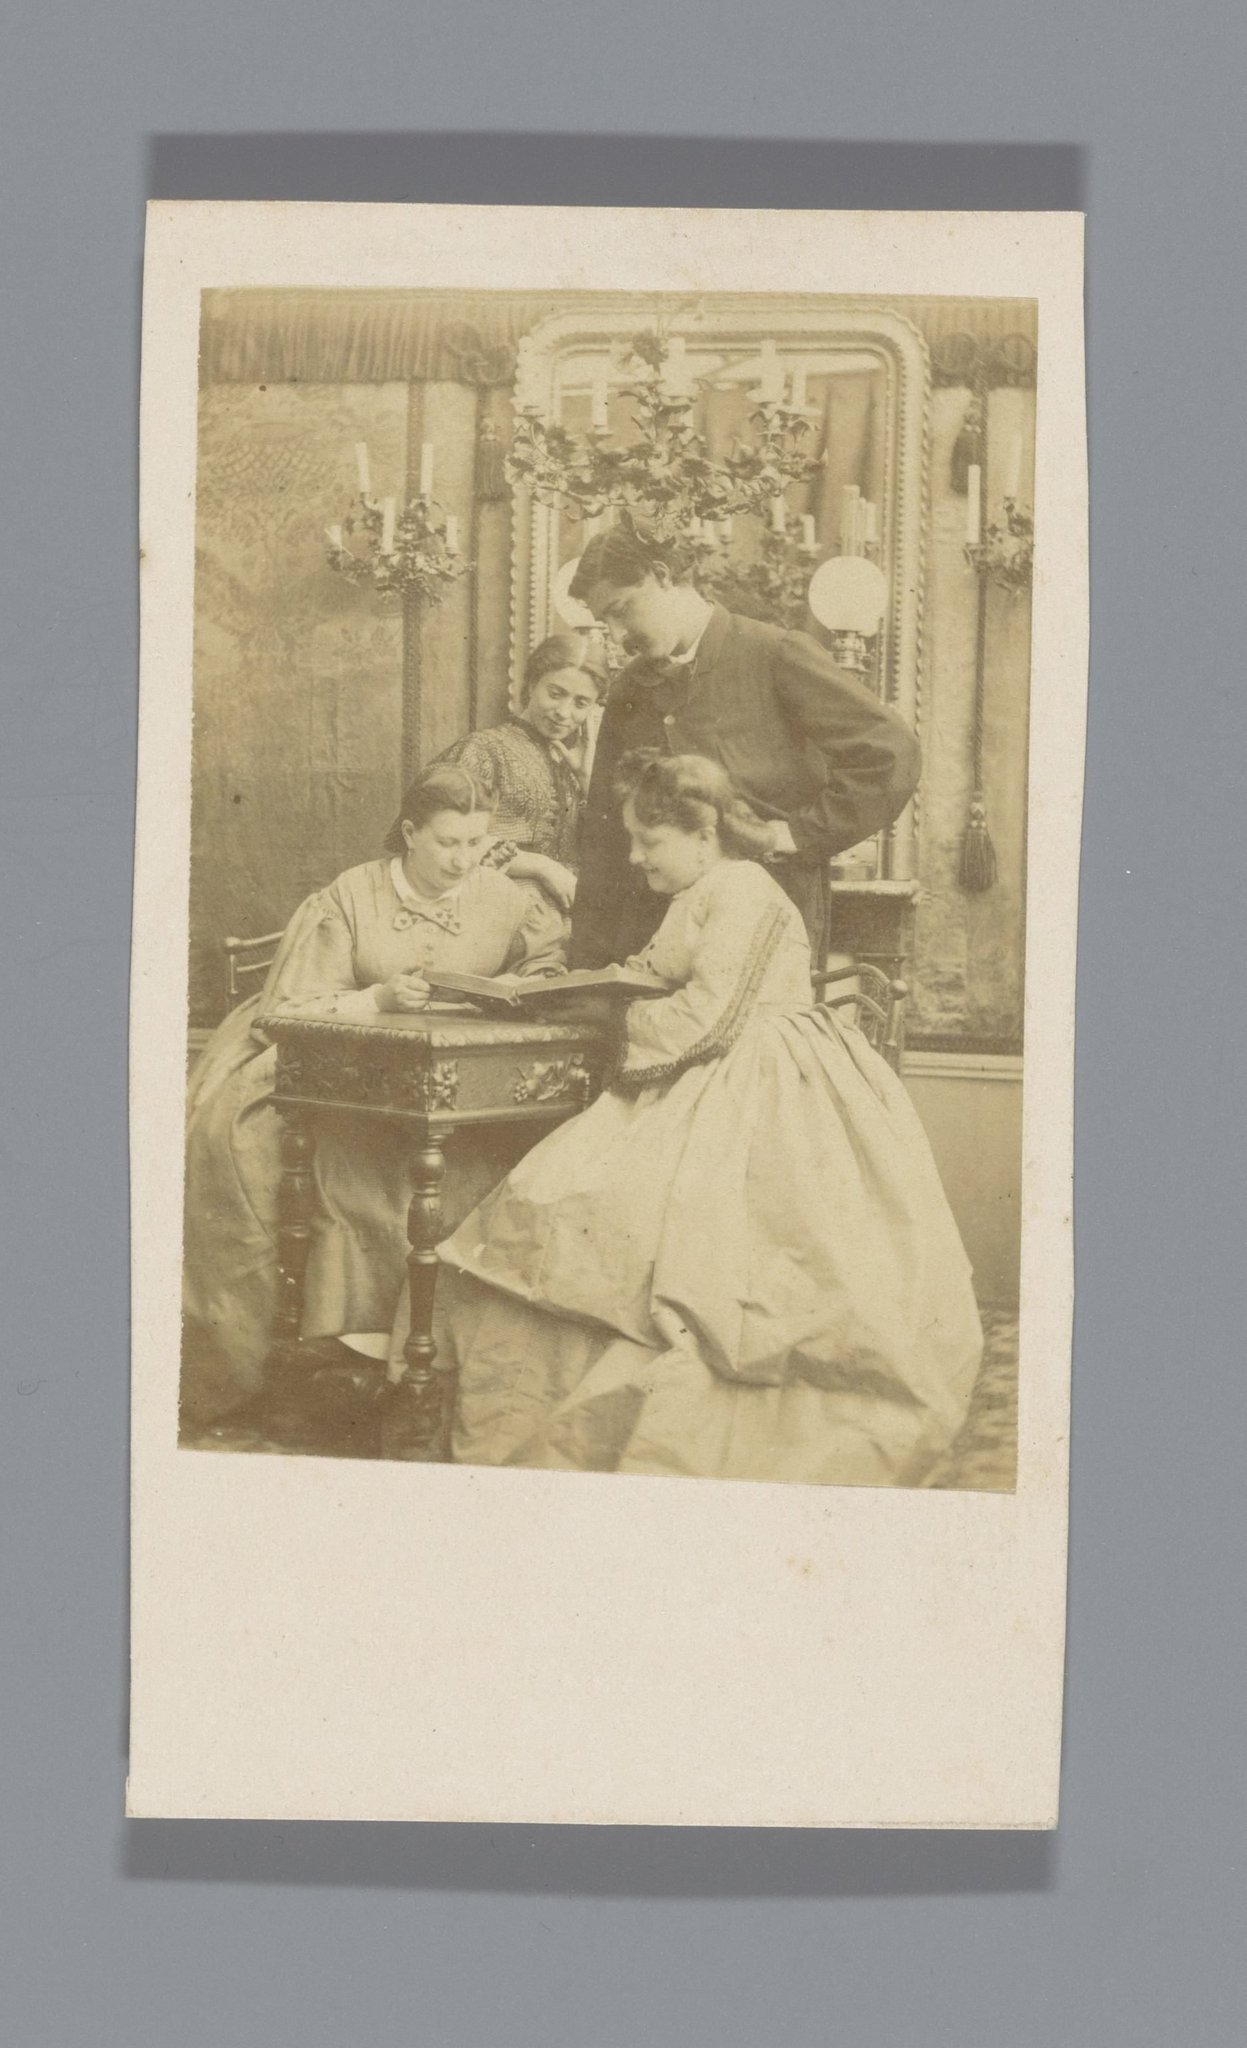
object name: photograph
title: Gezelschap aan tafel met album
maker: Anonymous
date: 1865-1870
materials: cardboard, paper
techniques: albumen print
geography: paris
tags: book in which illustrations are essential, paris